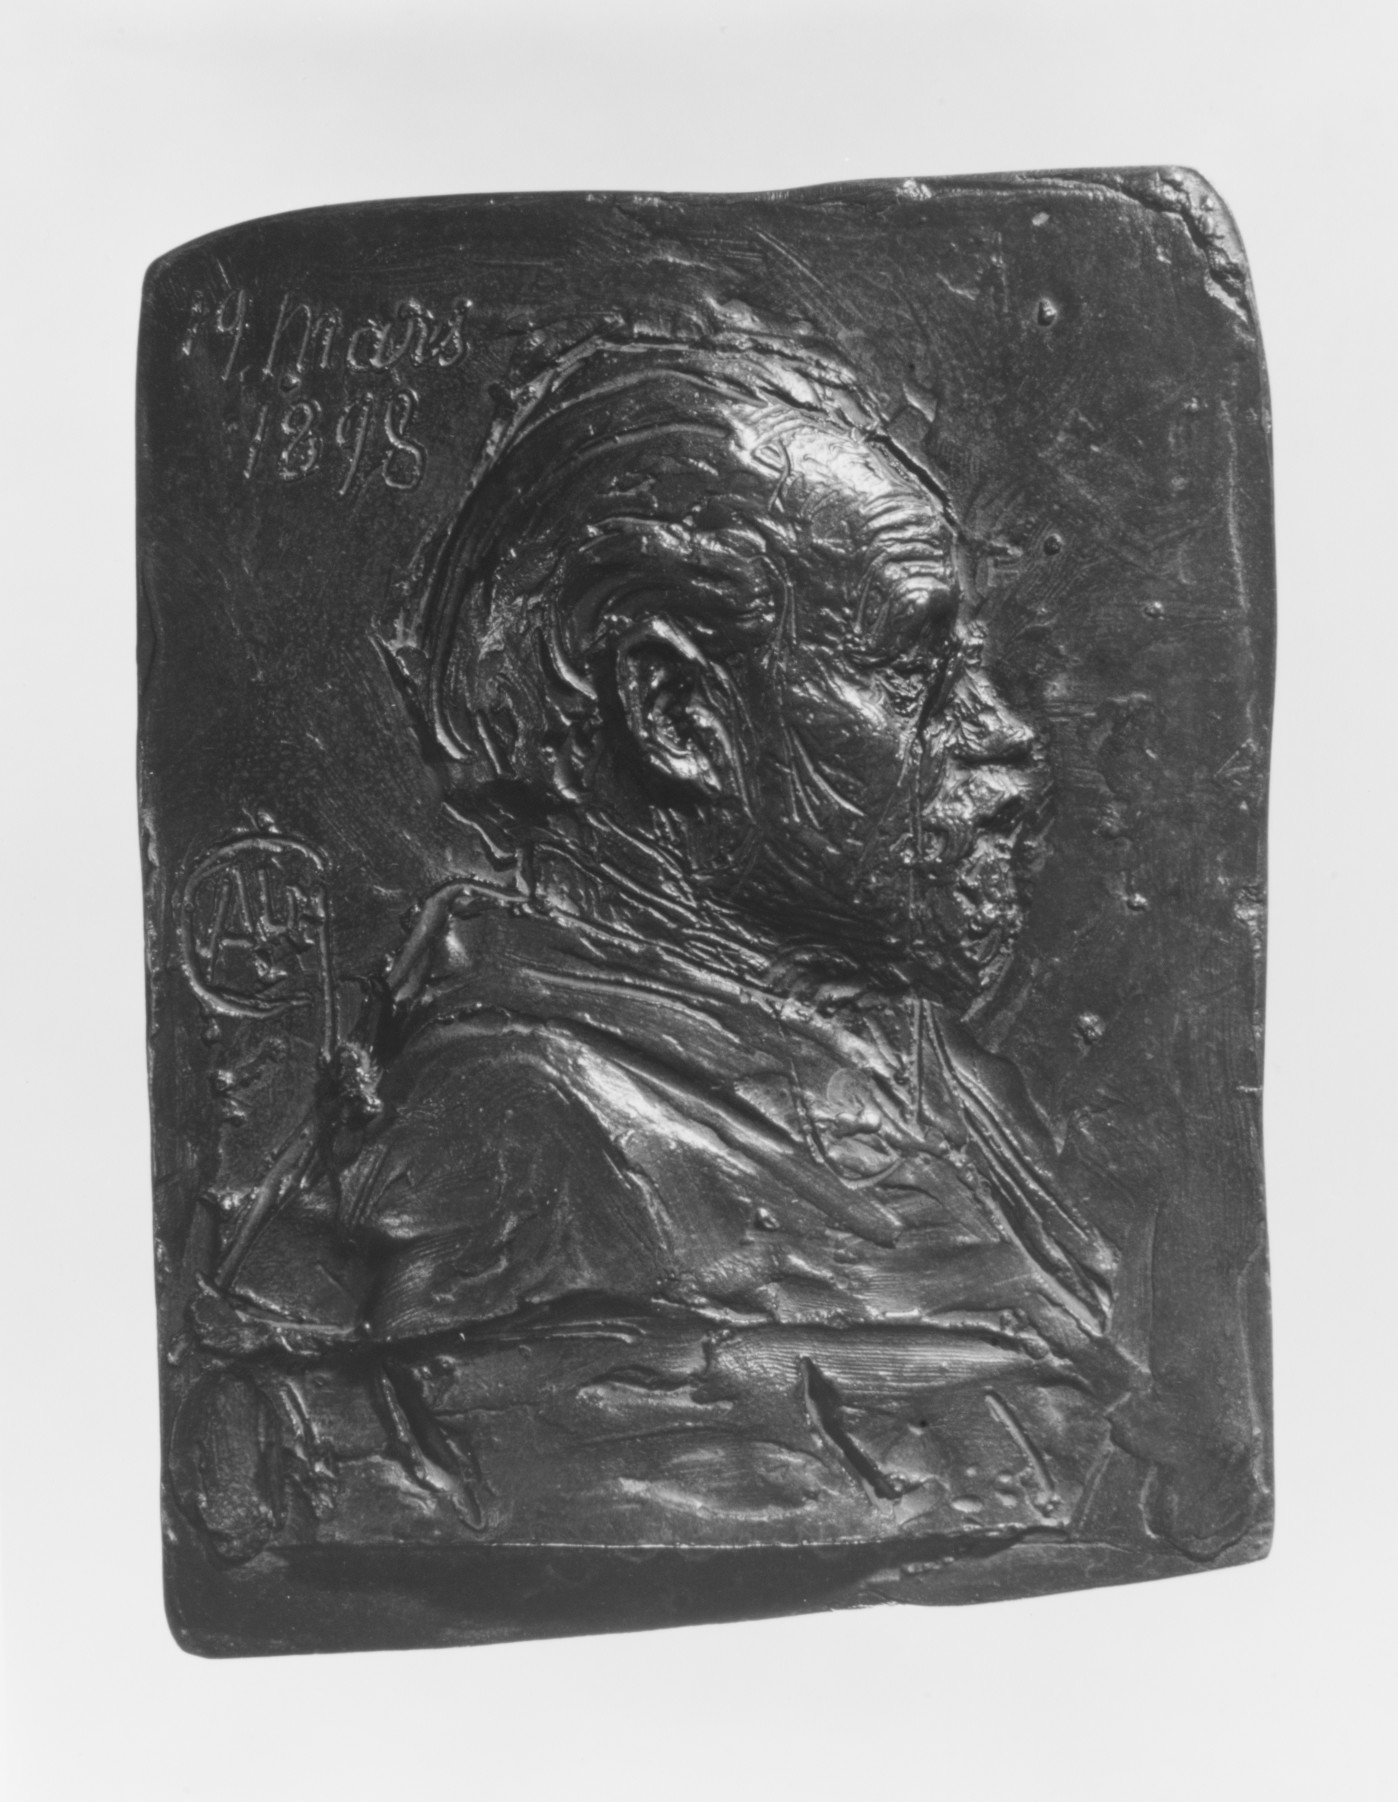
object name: relief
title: Portrait Relief of Émile Zola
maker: alexandre-louis-marie charpentier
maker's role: artist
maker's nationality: french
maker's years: 1856-1909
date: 1898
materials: bronze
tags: men,profiles